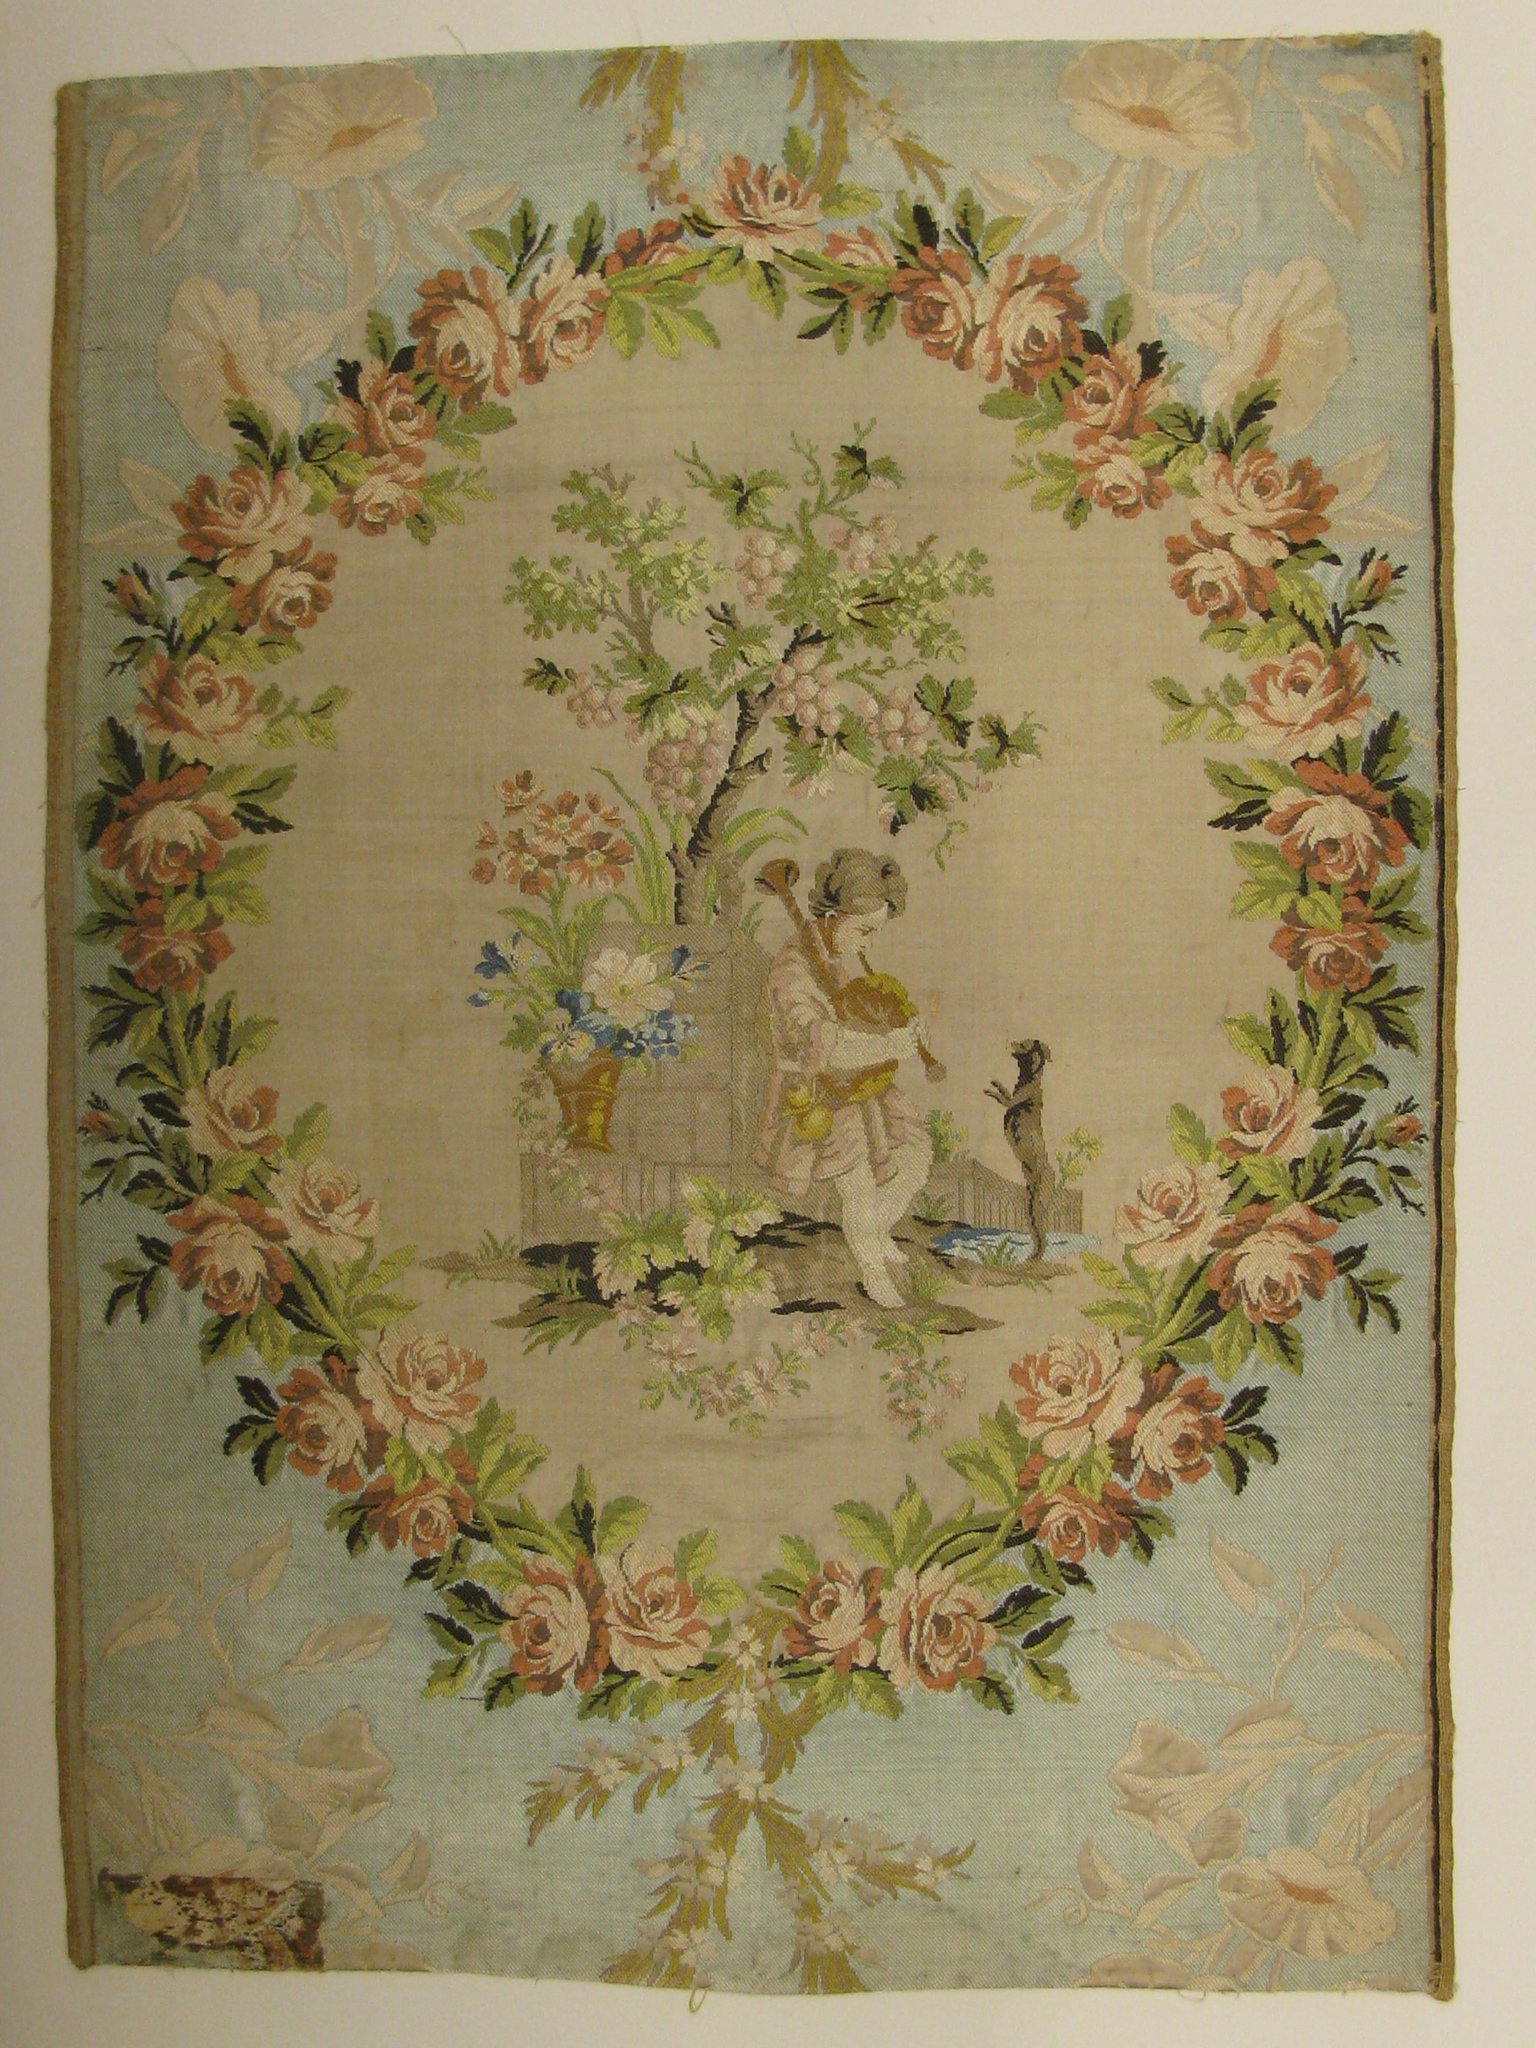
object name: upholstery panel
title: Length of upholstery silk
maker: philippe de lasalle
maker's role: designer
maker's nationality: french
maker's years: 1723-1804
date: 1771-1772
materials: silk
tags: boys,flowers,trees,wreaths